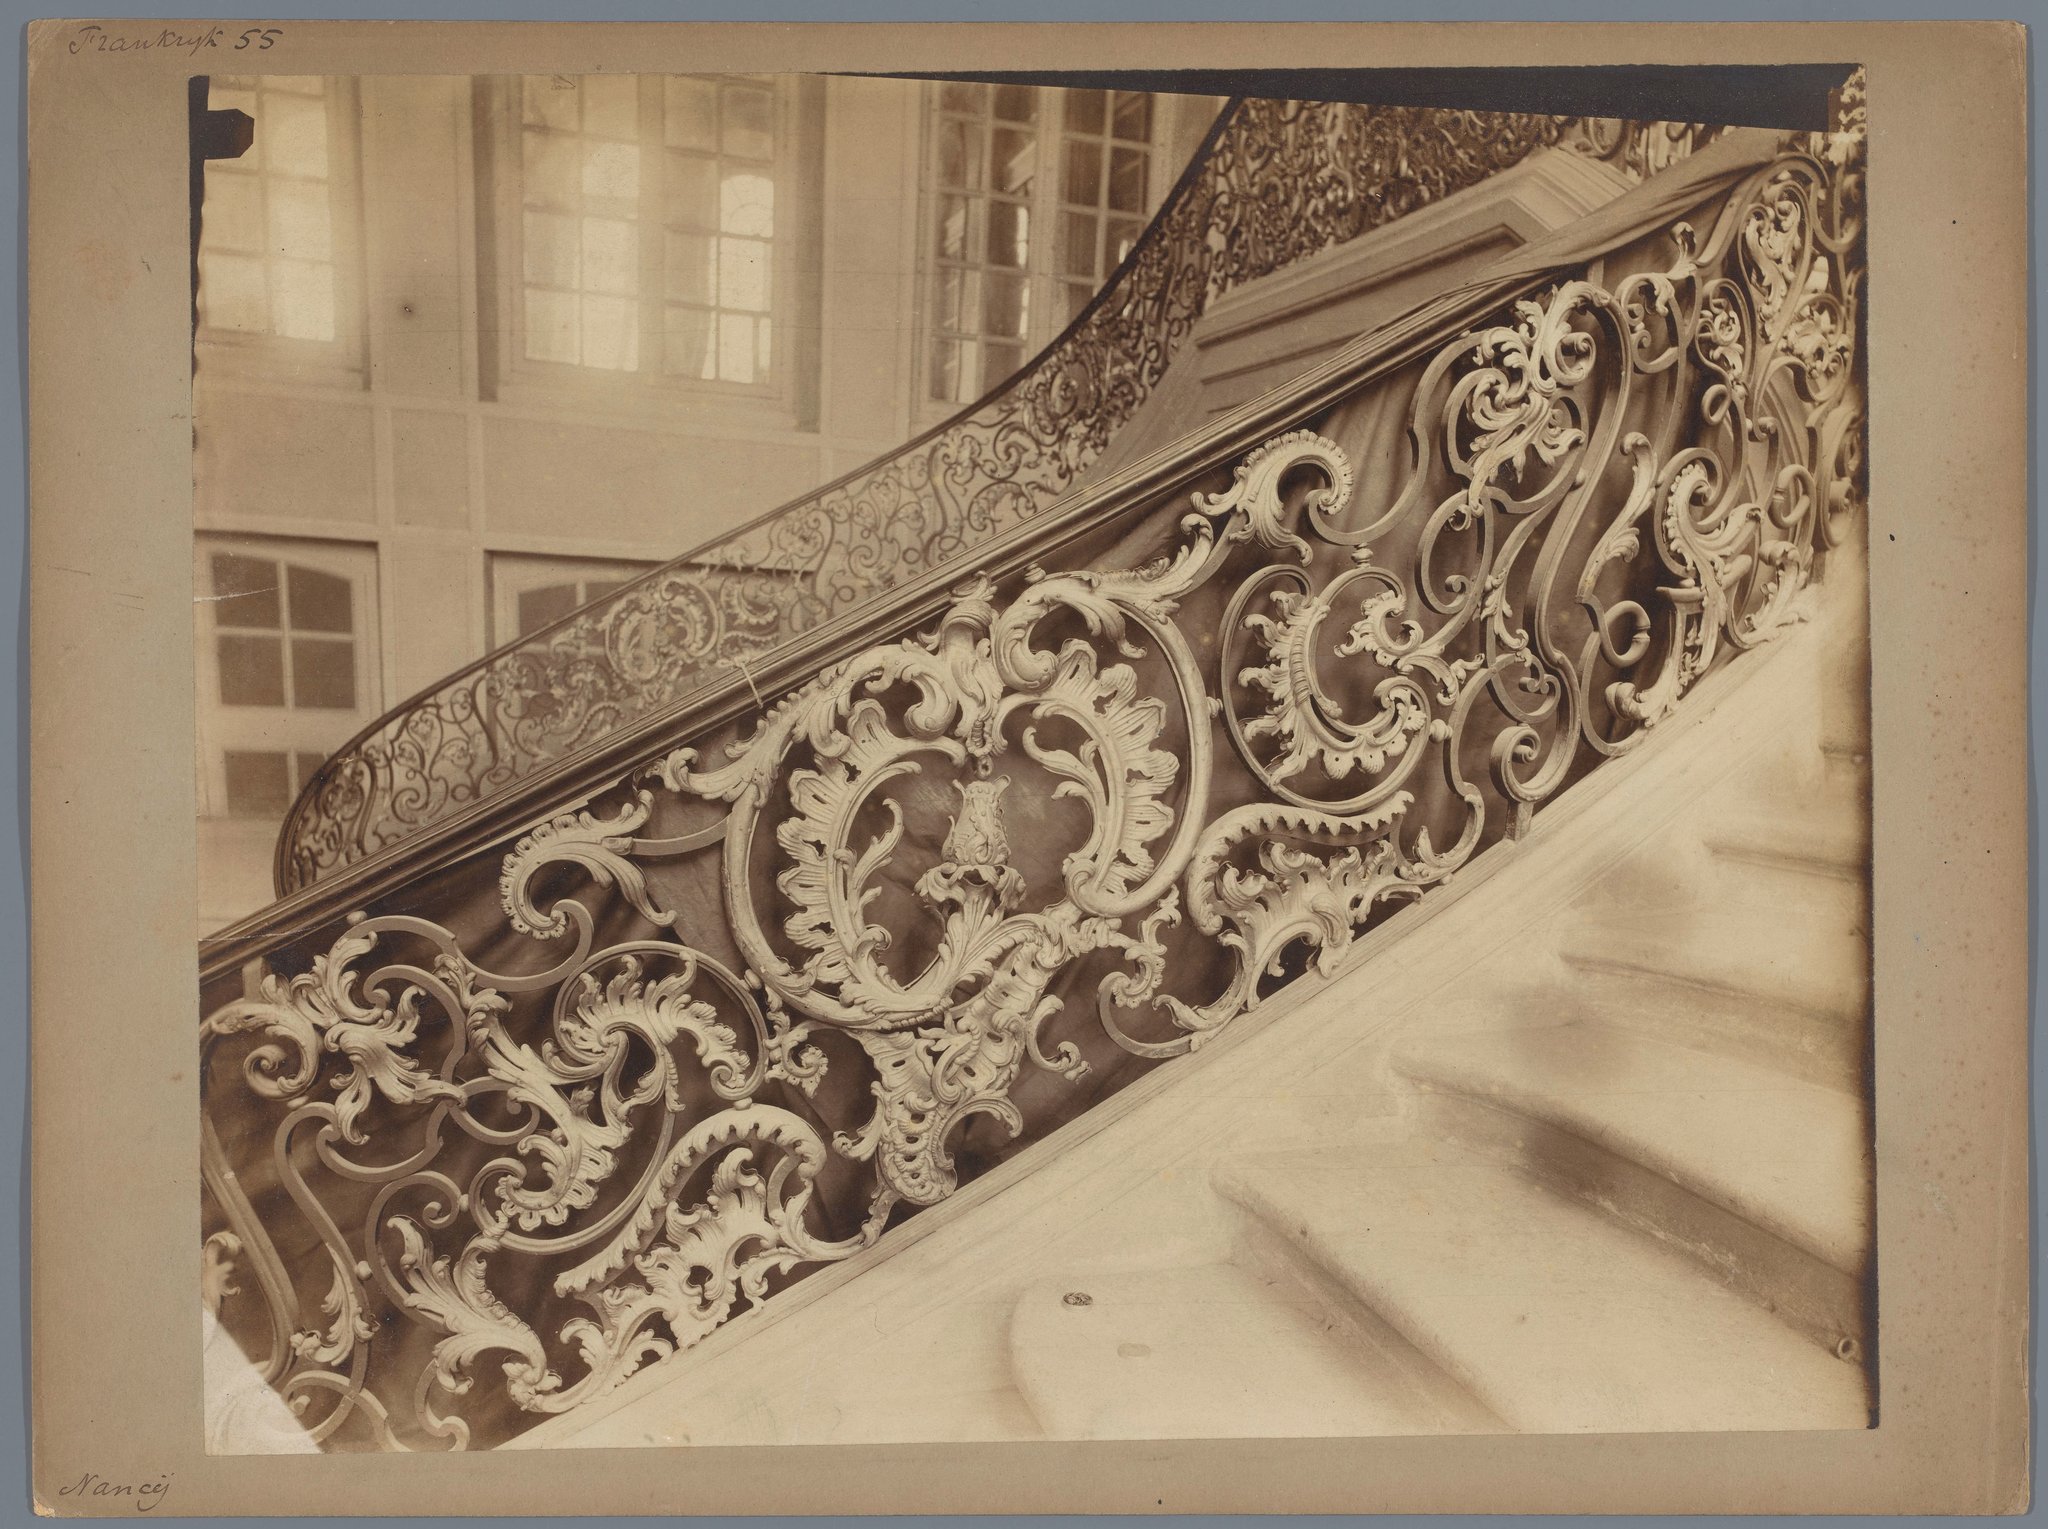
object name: photograph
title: Gedecoreerde trapleuning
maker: Anonymous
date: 1850-1900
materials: cardboard, photographic support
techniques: albumen print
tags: stairwell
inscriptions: annotation: ‘Frankrijk 55’, annotation: ‘Nancy’, collector's mark: ‘RIJKS NORMAALSCHOOL voor T[EEKENONDERWIJZERS] AMSTERDA[M]’, annotation: ‘Nancij’